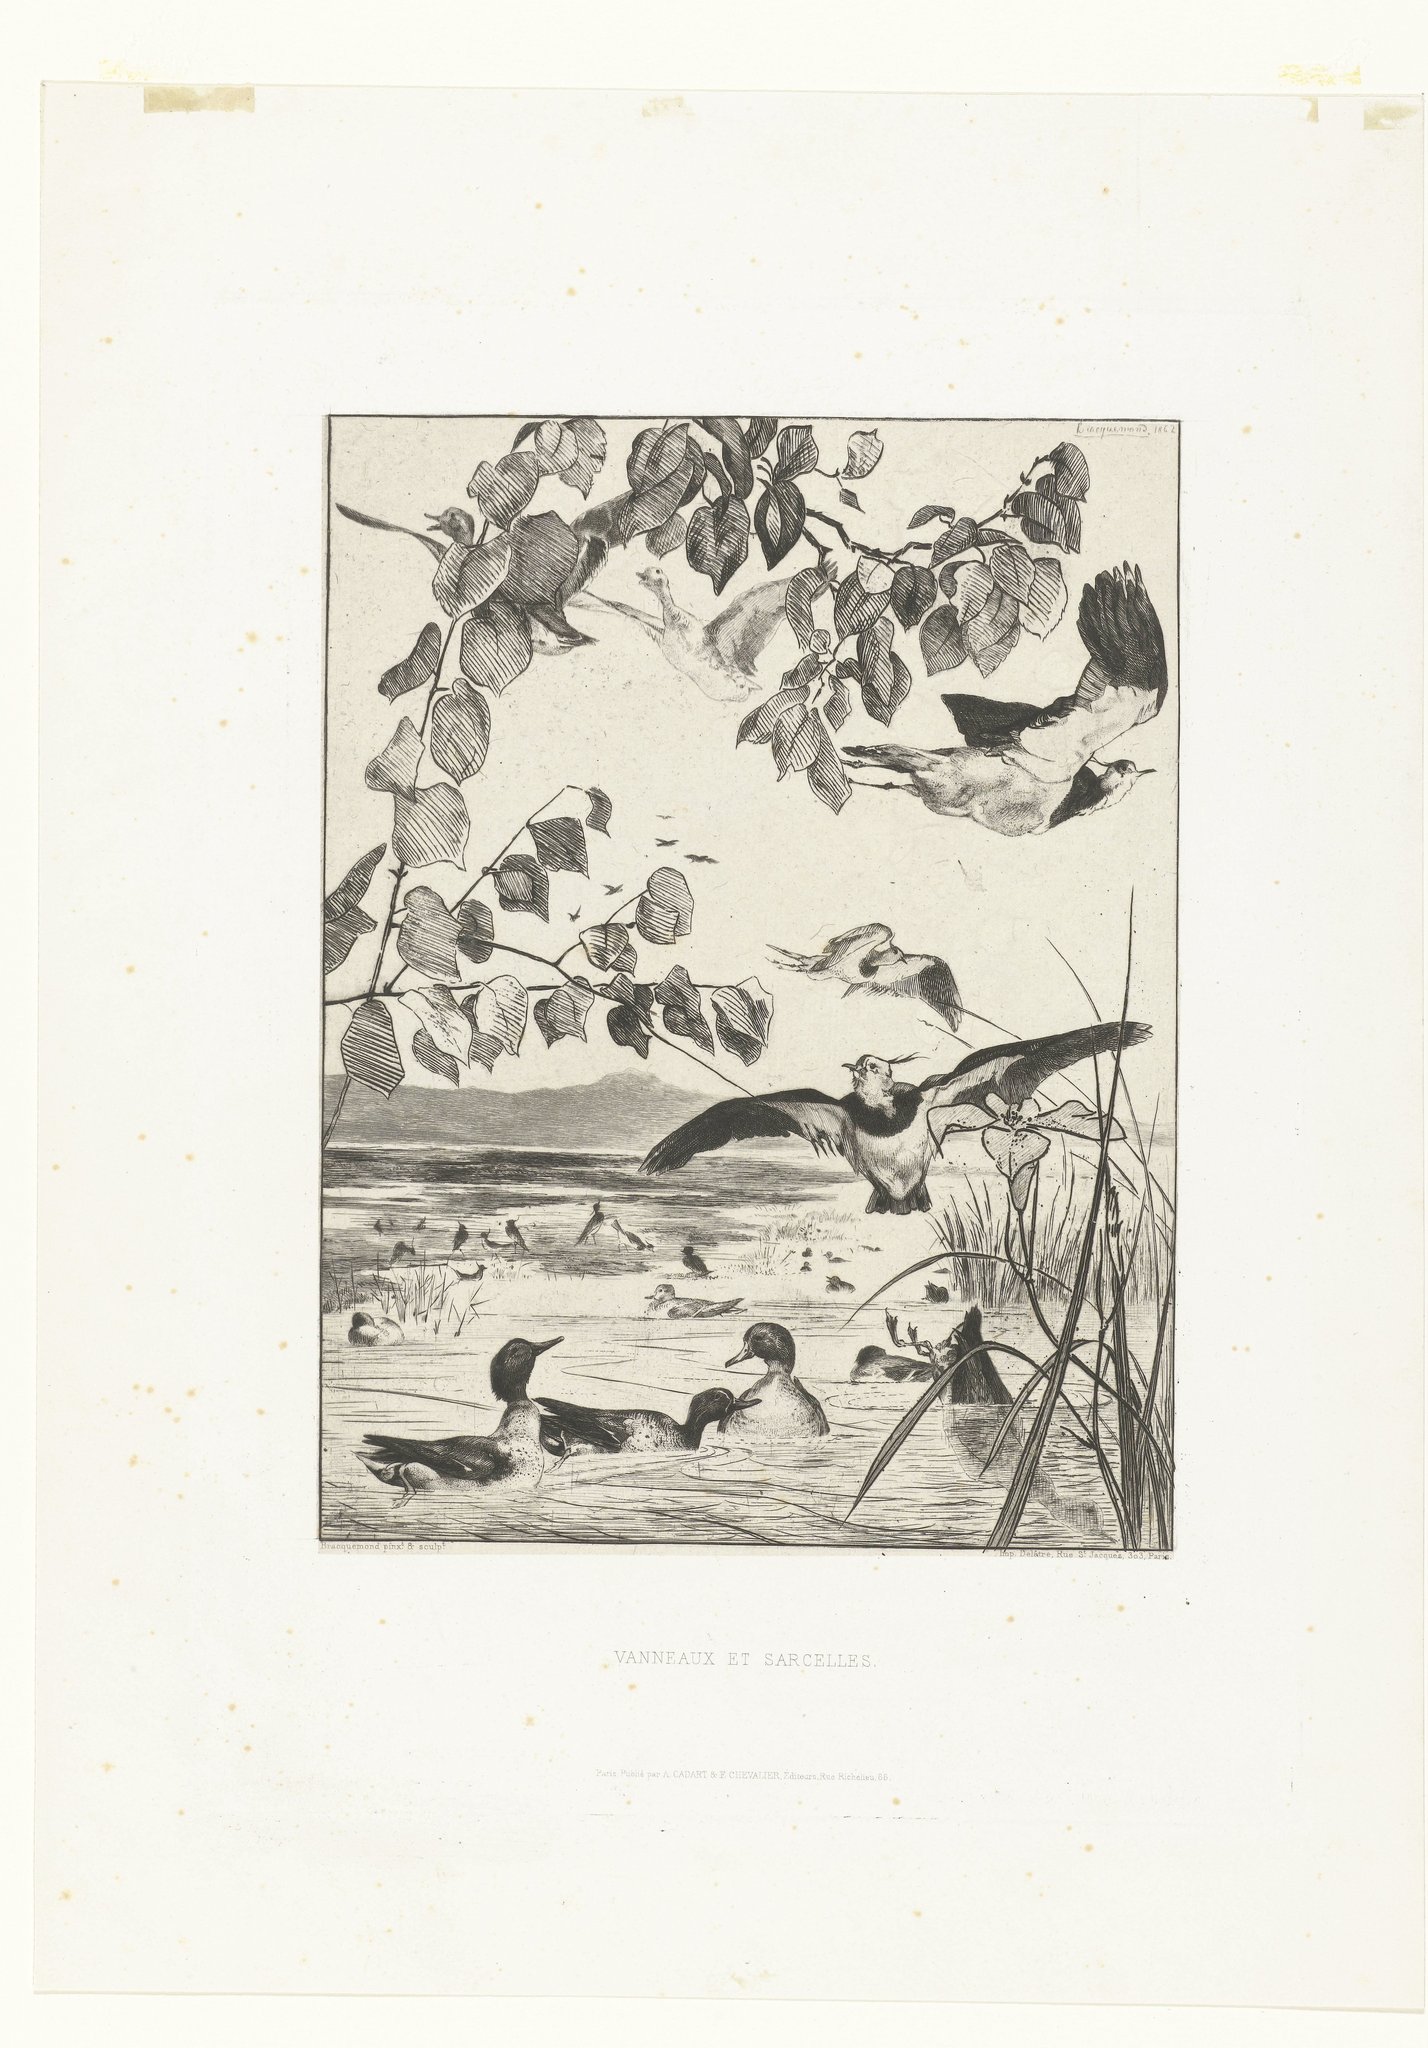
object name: print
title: Vanneaux en sarcelles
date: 1862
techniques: printmaking, etching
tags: landscapes with waters, waterscapes, seascapes (in the temperate zone), shore-birds and wading-birds: lapwing, water-birds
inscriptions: collector's mark, collector's mark: Lugt 2228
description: Gepubliceerd door: Société des Aquafortistes, Auguste Delatre (drukker), Cadart & Chevalier (uitgever), 1863.